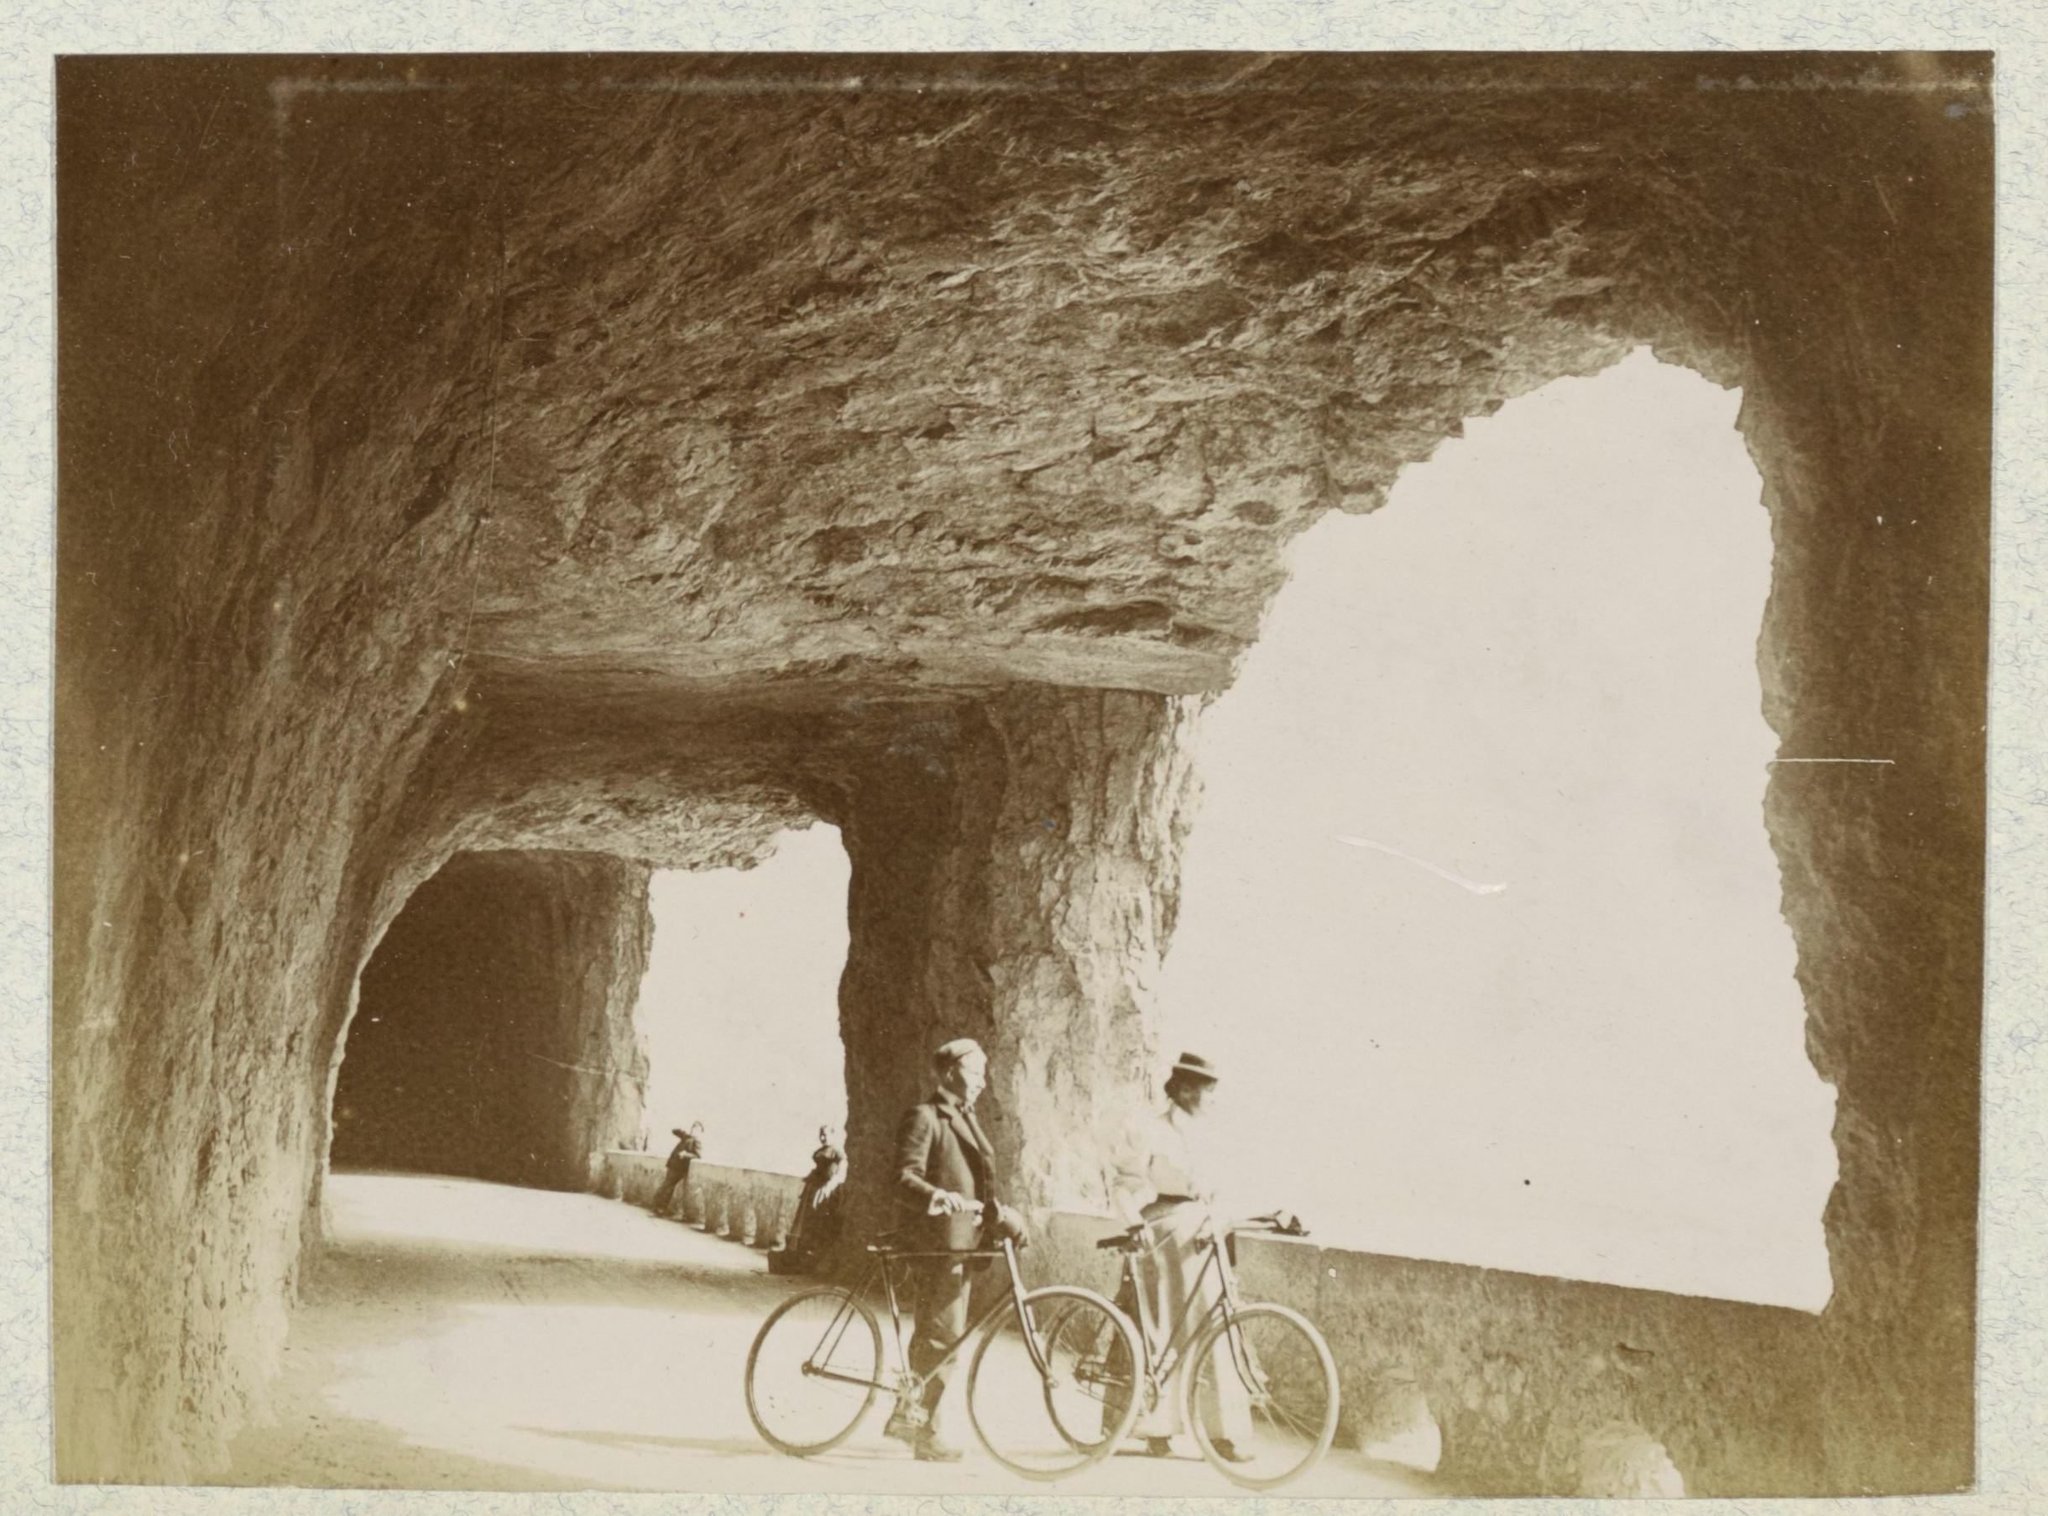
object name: photograph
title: Vakantie in Zwitserland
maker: andries augustus boom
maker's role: amateurfotograaf, handelaar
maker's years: 1878-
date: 1805-1899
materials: photographic support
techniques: photography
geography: switzerland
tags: amsterdam, andries augustus boom, switzerland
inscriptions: date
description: Vakantie in Zwitserland, de Axenstrasse. Onderdeel van het fotoalbum van de familie Boom-Gonggrijp in Suriname en Curaçao.